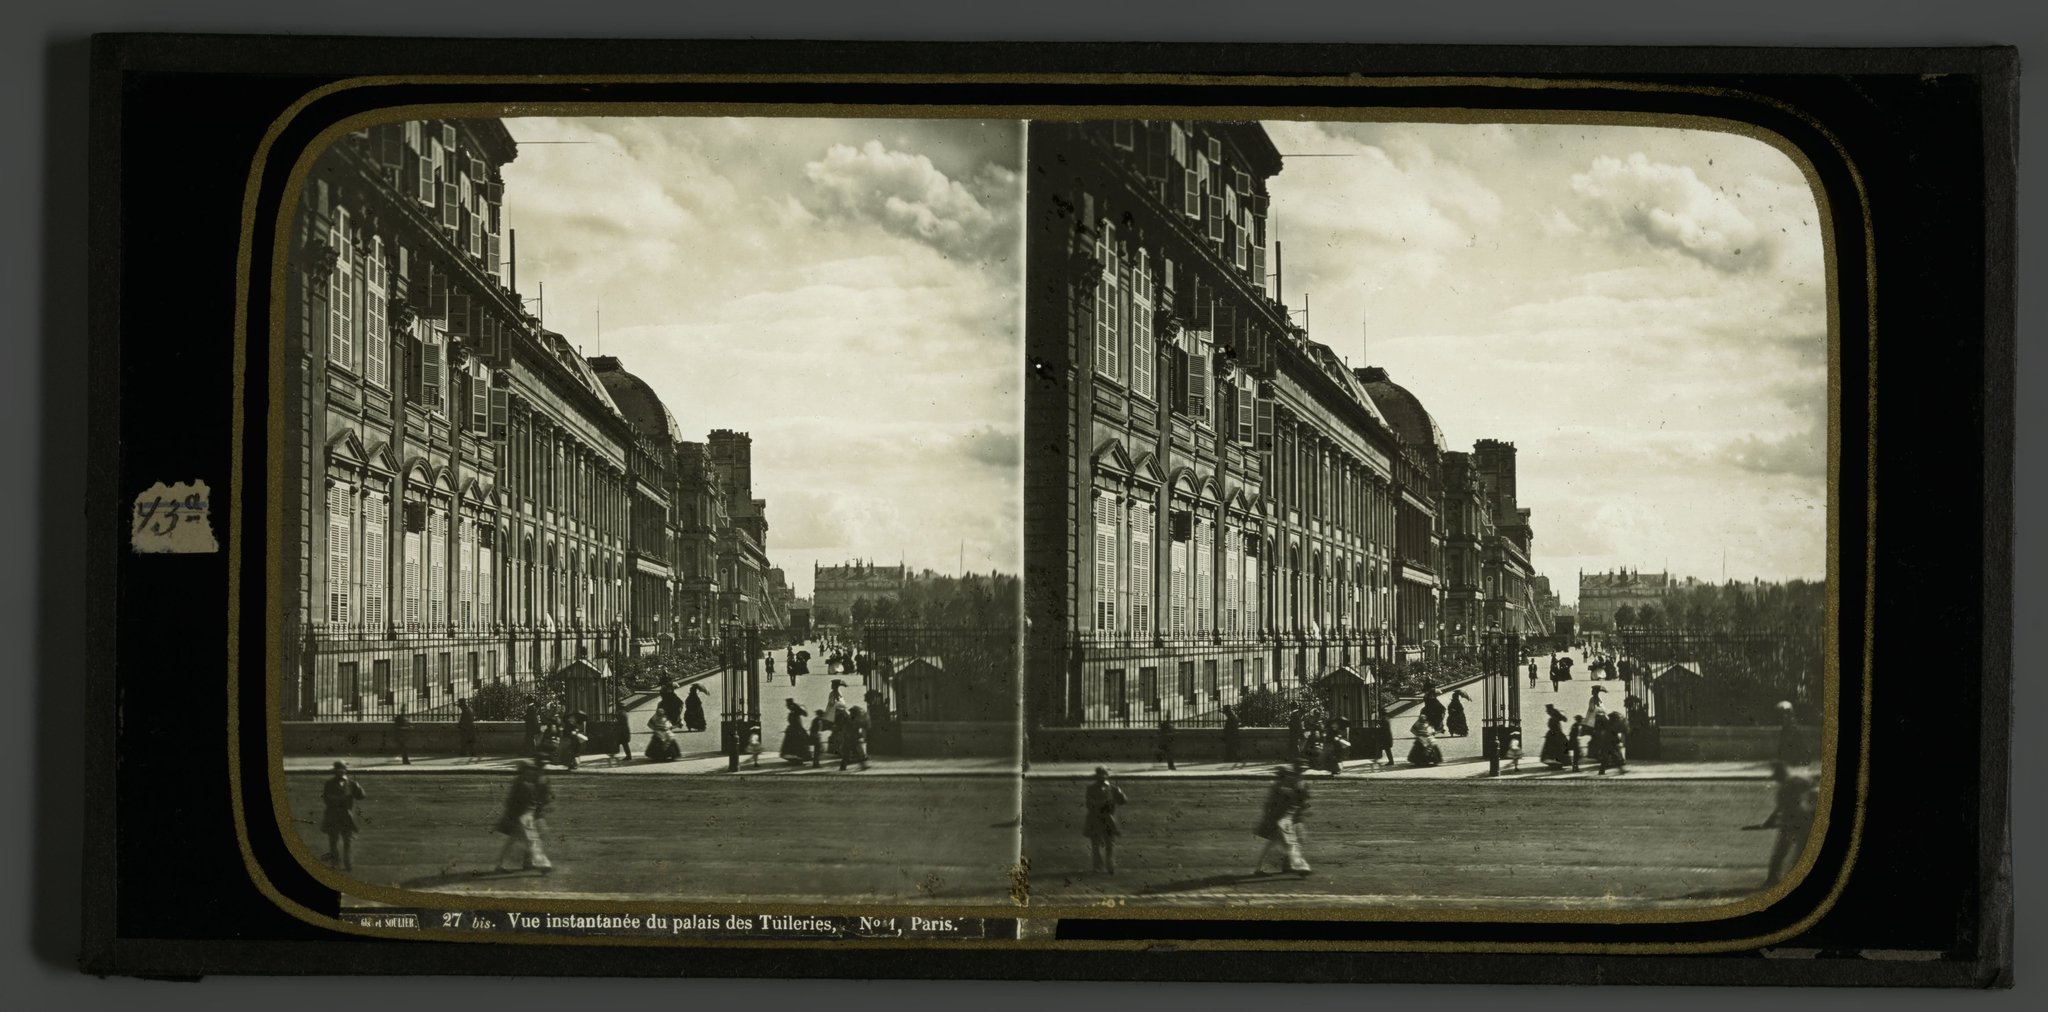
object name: stereoscopic photograph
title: Vue instantanée du palais des Tuileries. No 1, Paris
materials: glass, paper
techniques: slide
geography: paris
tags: park, palace, tuileries palace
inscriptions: number: ‘27 bis’, number: ‘93a’